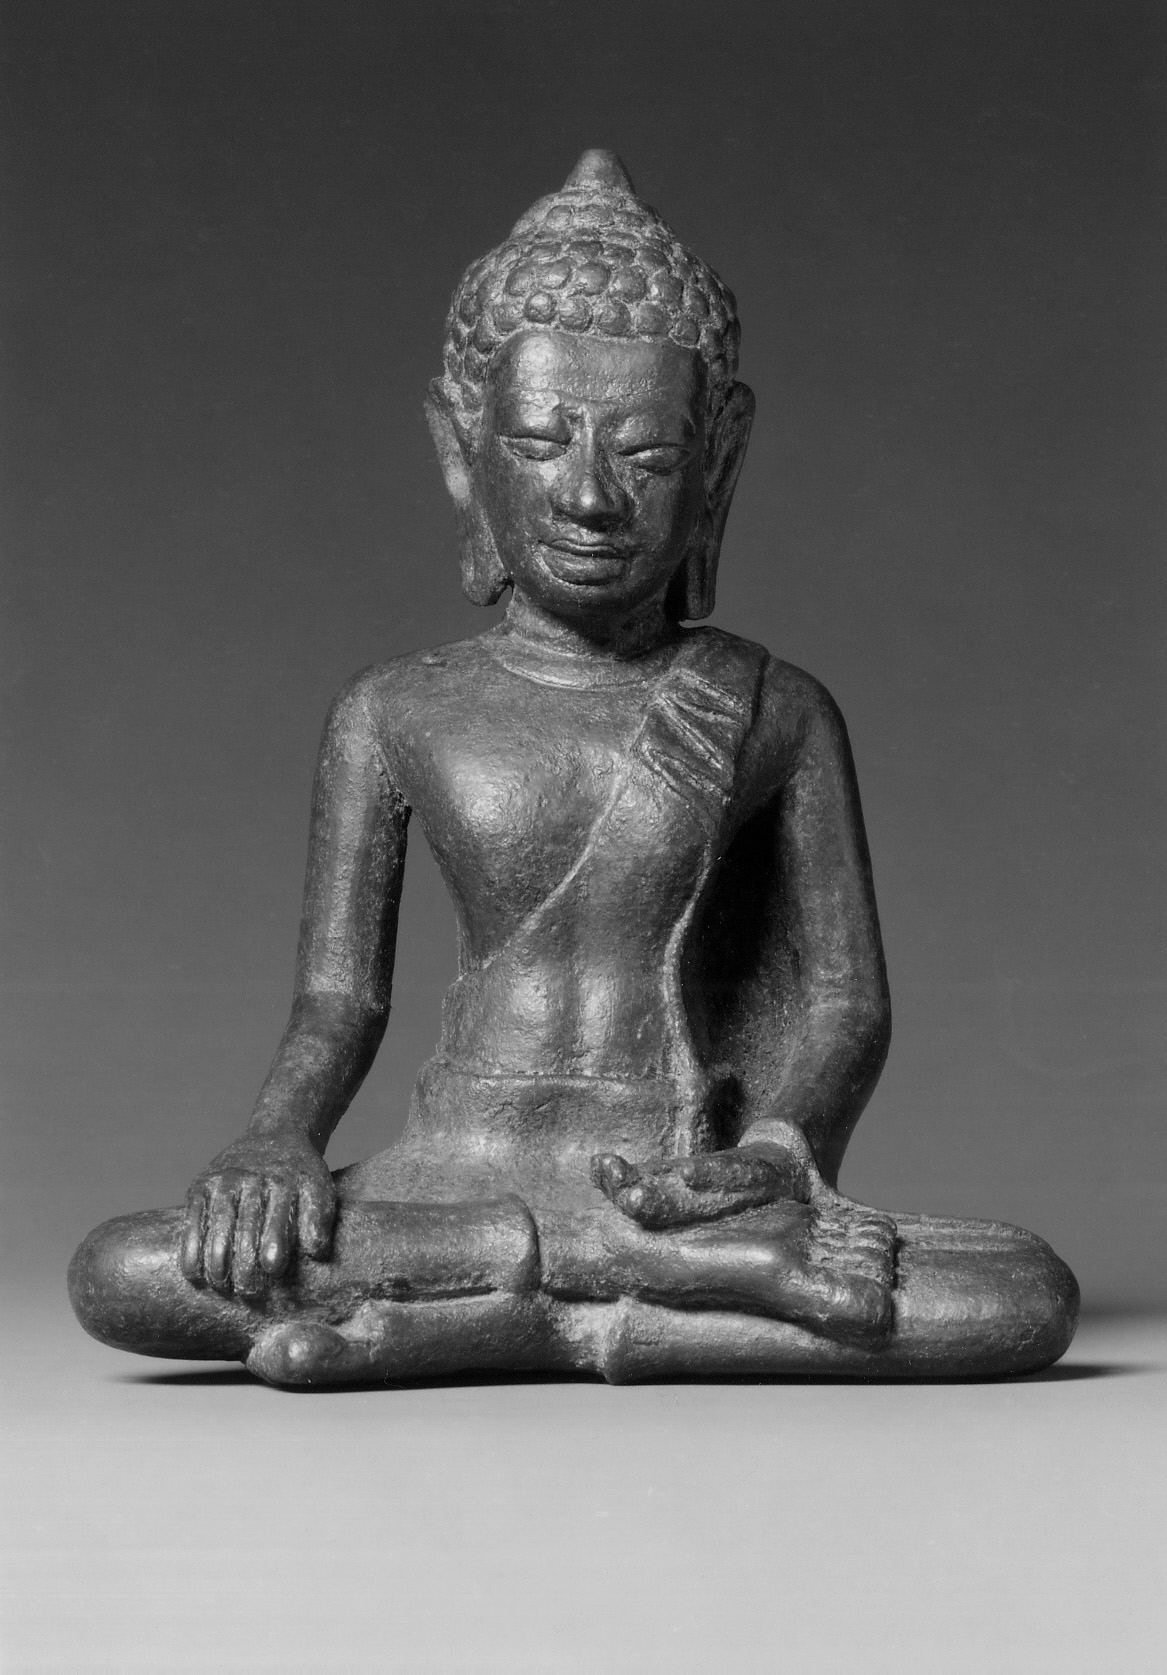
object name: figurine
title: Seated Buddha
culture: thai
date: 801-900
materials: bronze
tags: buddha